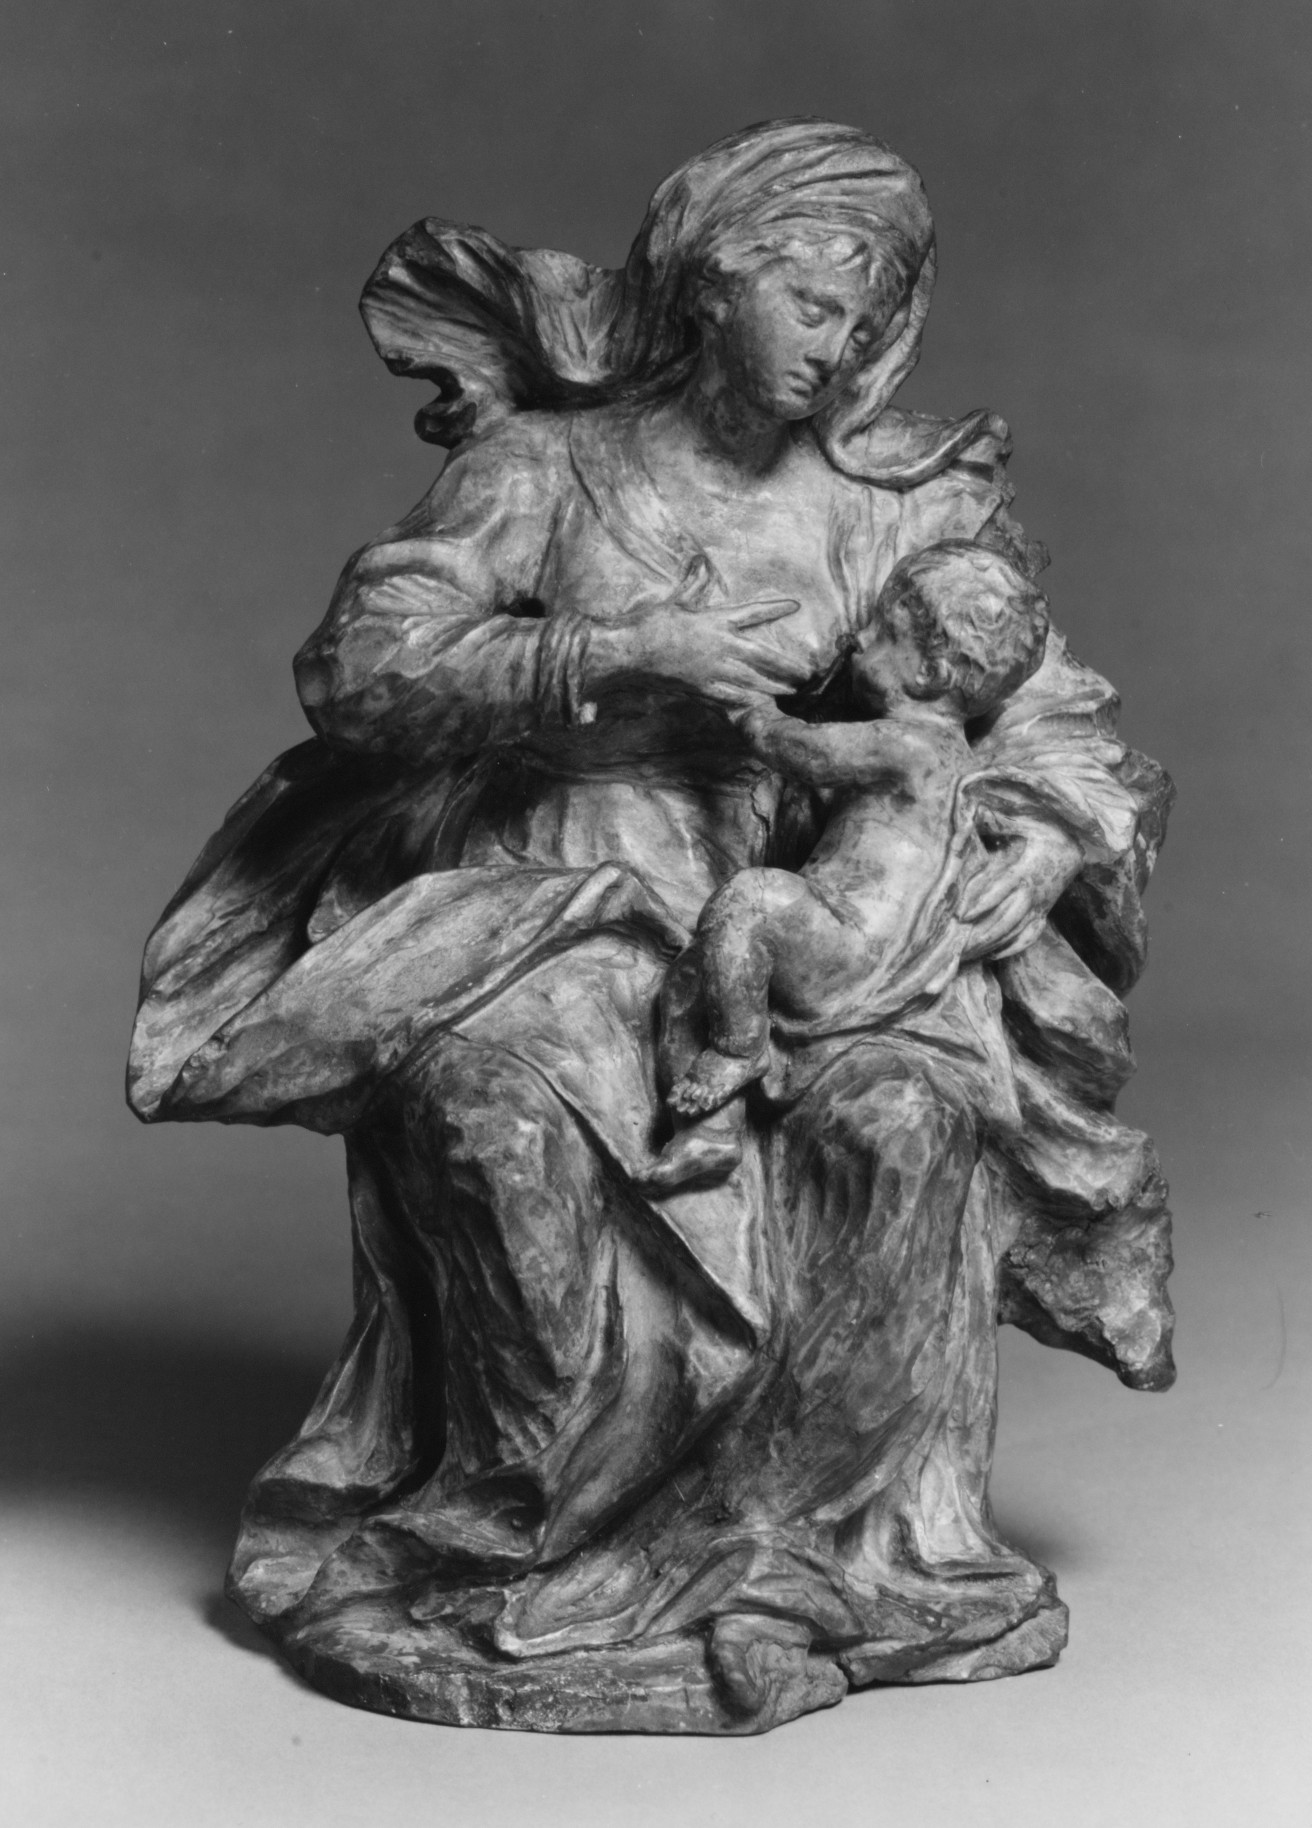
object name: statuette group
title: Virgin and Child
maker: giovanni giuliani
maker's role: artist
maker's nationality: italian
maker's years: 1663-1744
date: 1736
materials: patina, terracotta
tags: madonna and child